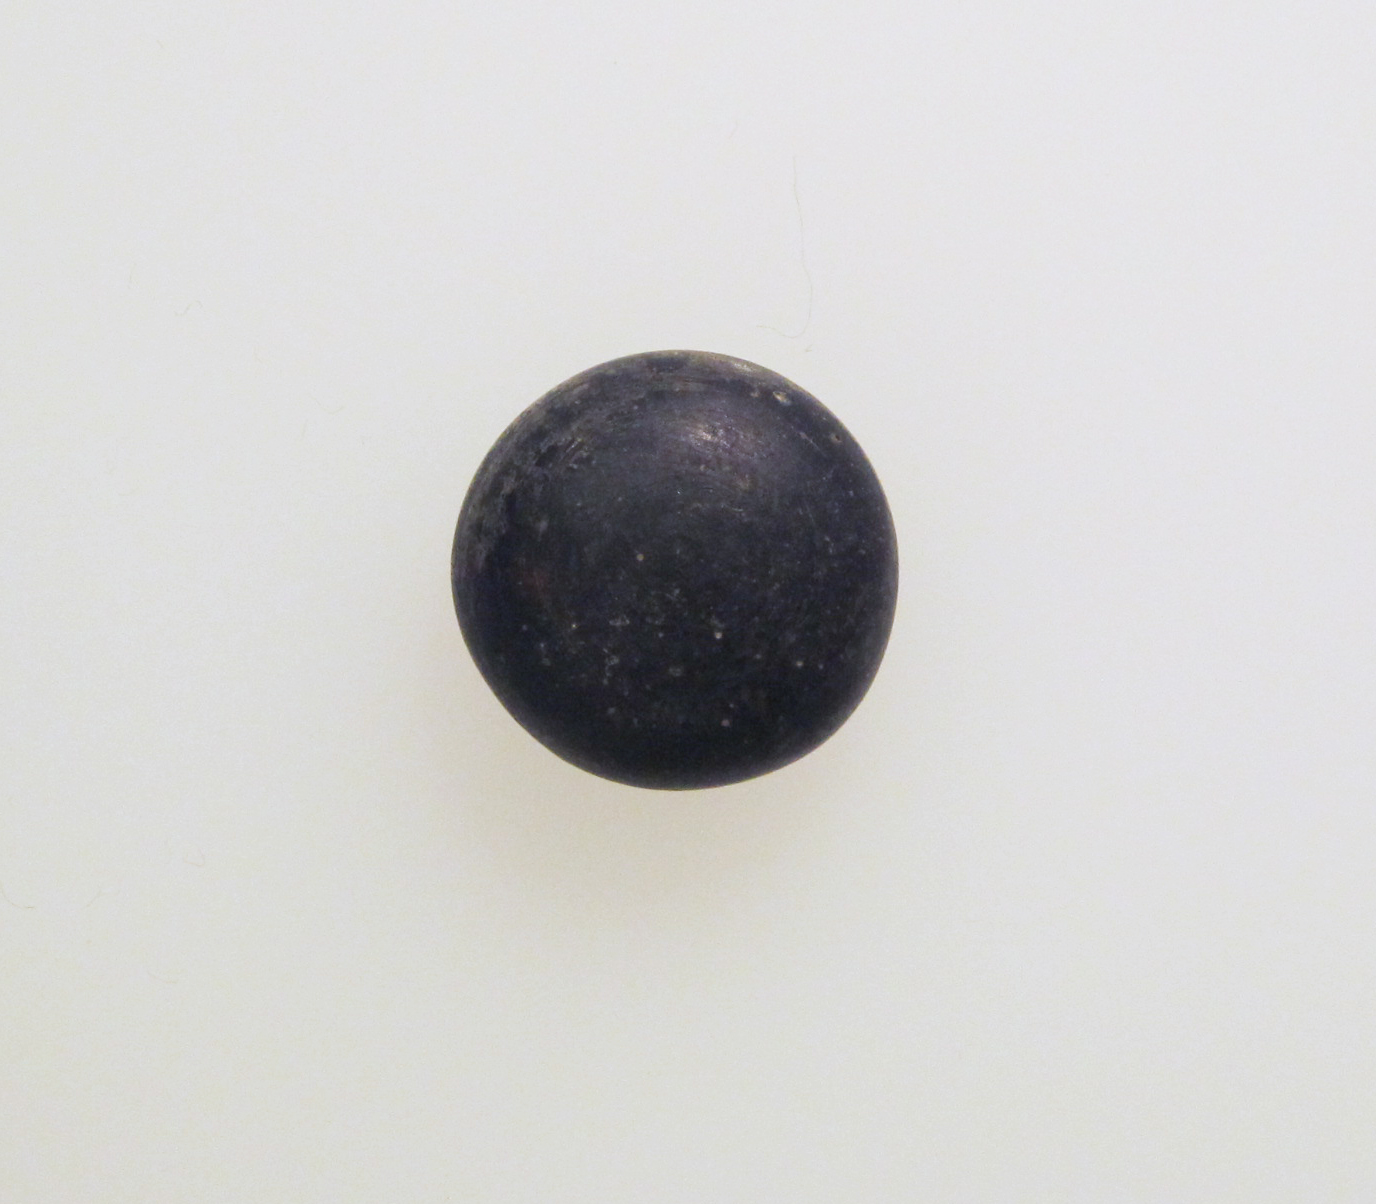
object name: pinhead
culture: roman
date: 100 BCE-500 CE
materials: glass